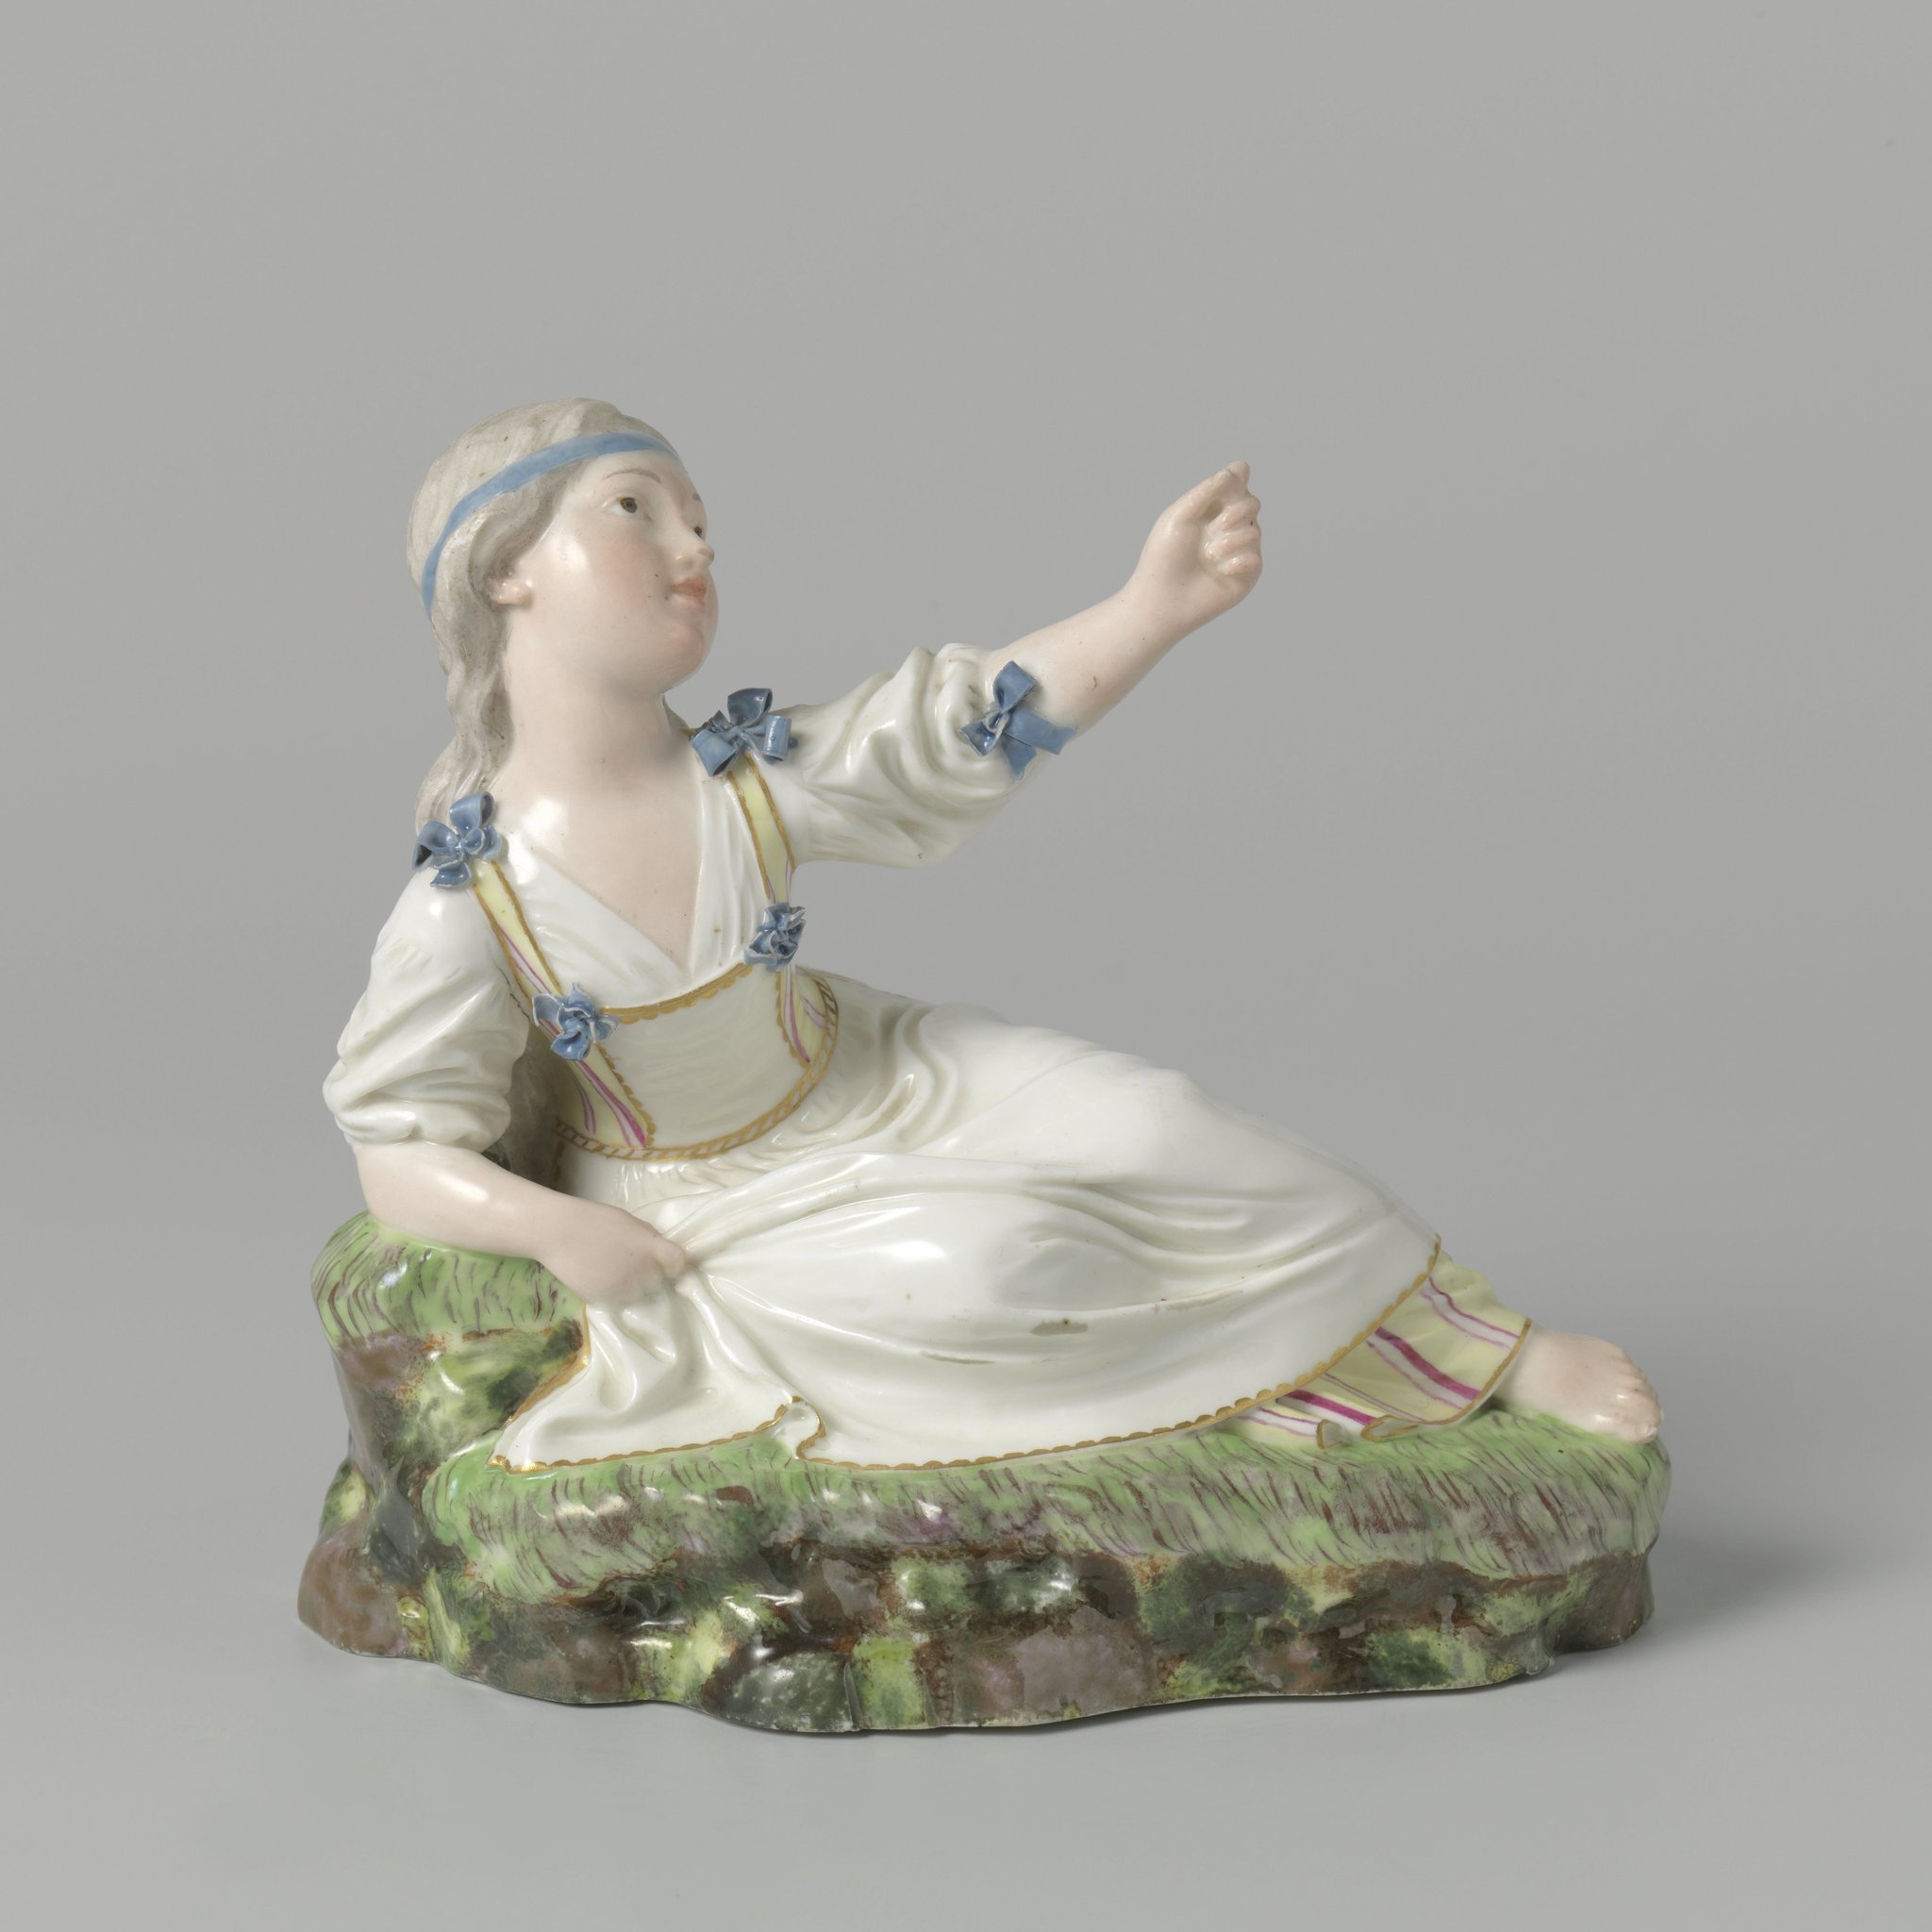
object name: figure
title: Figure of a reclining girl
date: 1770-1780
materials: glaze, gold, paint, porcelain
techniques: firing, forming, gilding, vitrification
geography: höchst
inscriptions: mark: ‘wiel/ No. 179 RI’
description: Figure. Porcelain. Höchst, c. 1770 - 1780. Given by C.P. van Eeghen, 1908.